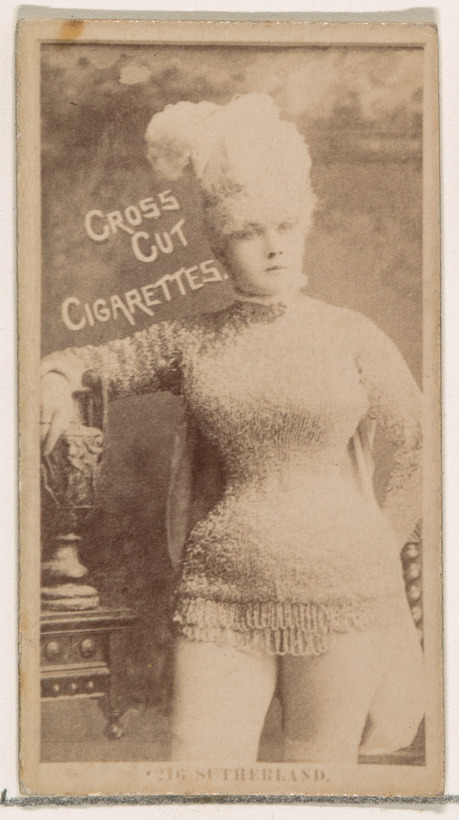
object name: print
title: Card Number 216, Sutherland, from the Actors and Actresses series (N145-2) issued by Duke Sons & Co. to promote Cross Cut Cigarettes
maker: w. duke, sons & co.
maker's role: publisher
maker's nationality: american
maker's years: 1870-1920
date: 1880-1889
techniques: albumen silver print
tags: portraits,women,actresses